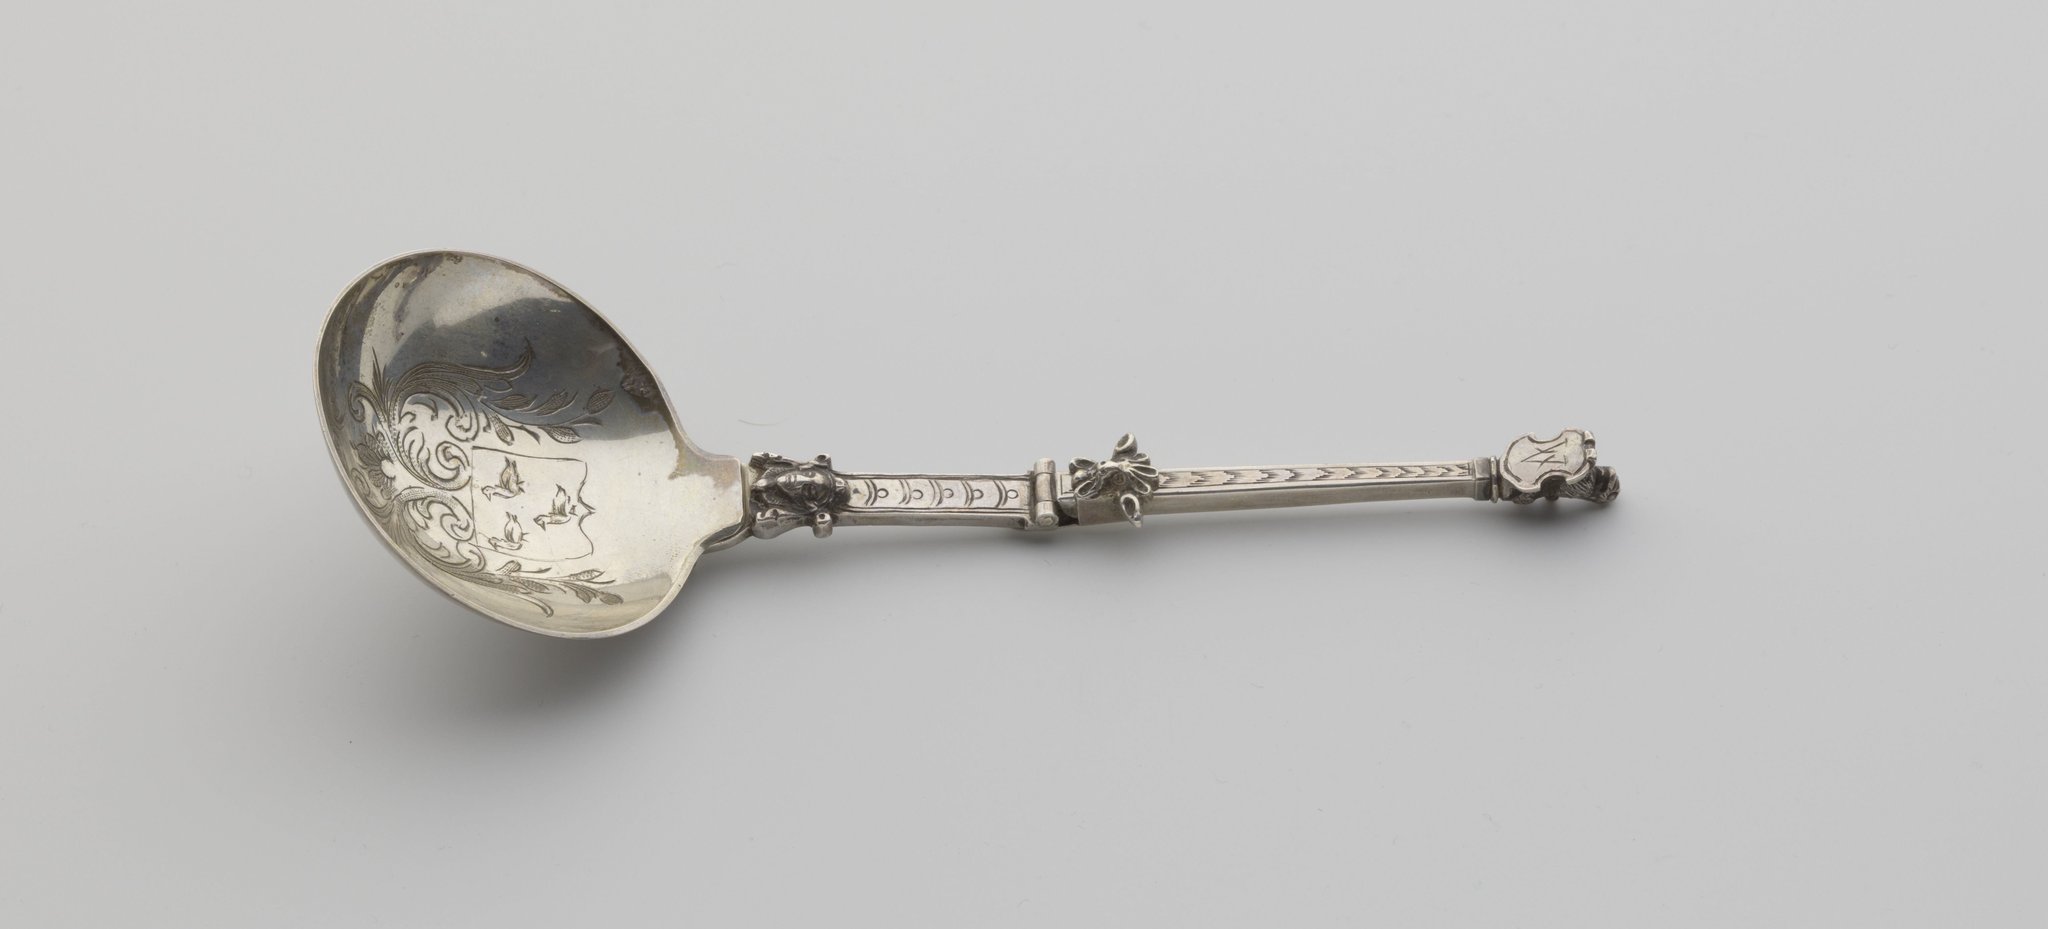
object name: spoon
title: Zilveren lepel en vork gecombineerd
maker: Anonymous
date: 1600-1650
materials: silver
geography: southern netherlands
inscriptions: mark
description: De vork kan door middel van een scharnier gebogen worden. De ronde bak van de lepel is voorzien van vijf ringen ter bevestiging van de vork. Merk: een dolfijn in een driehoek (3x).